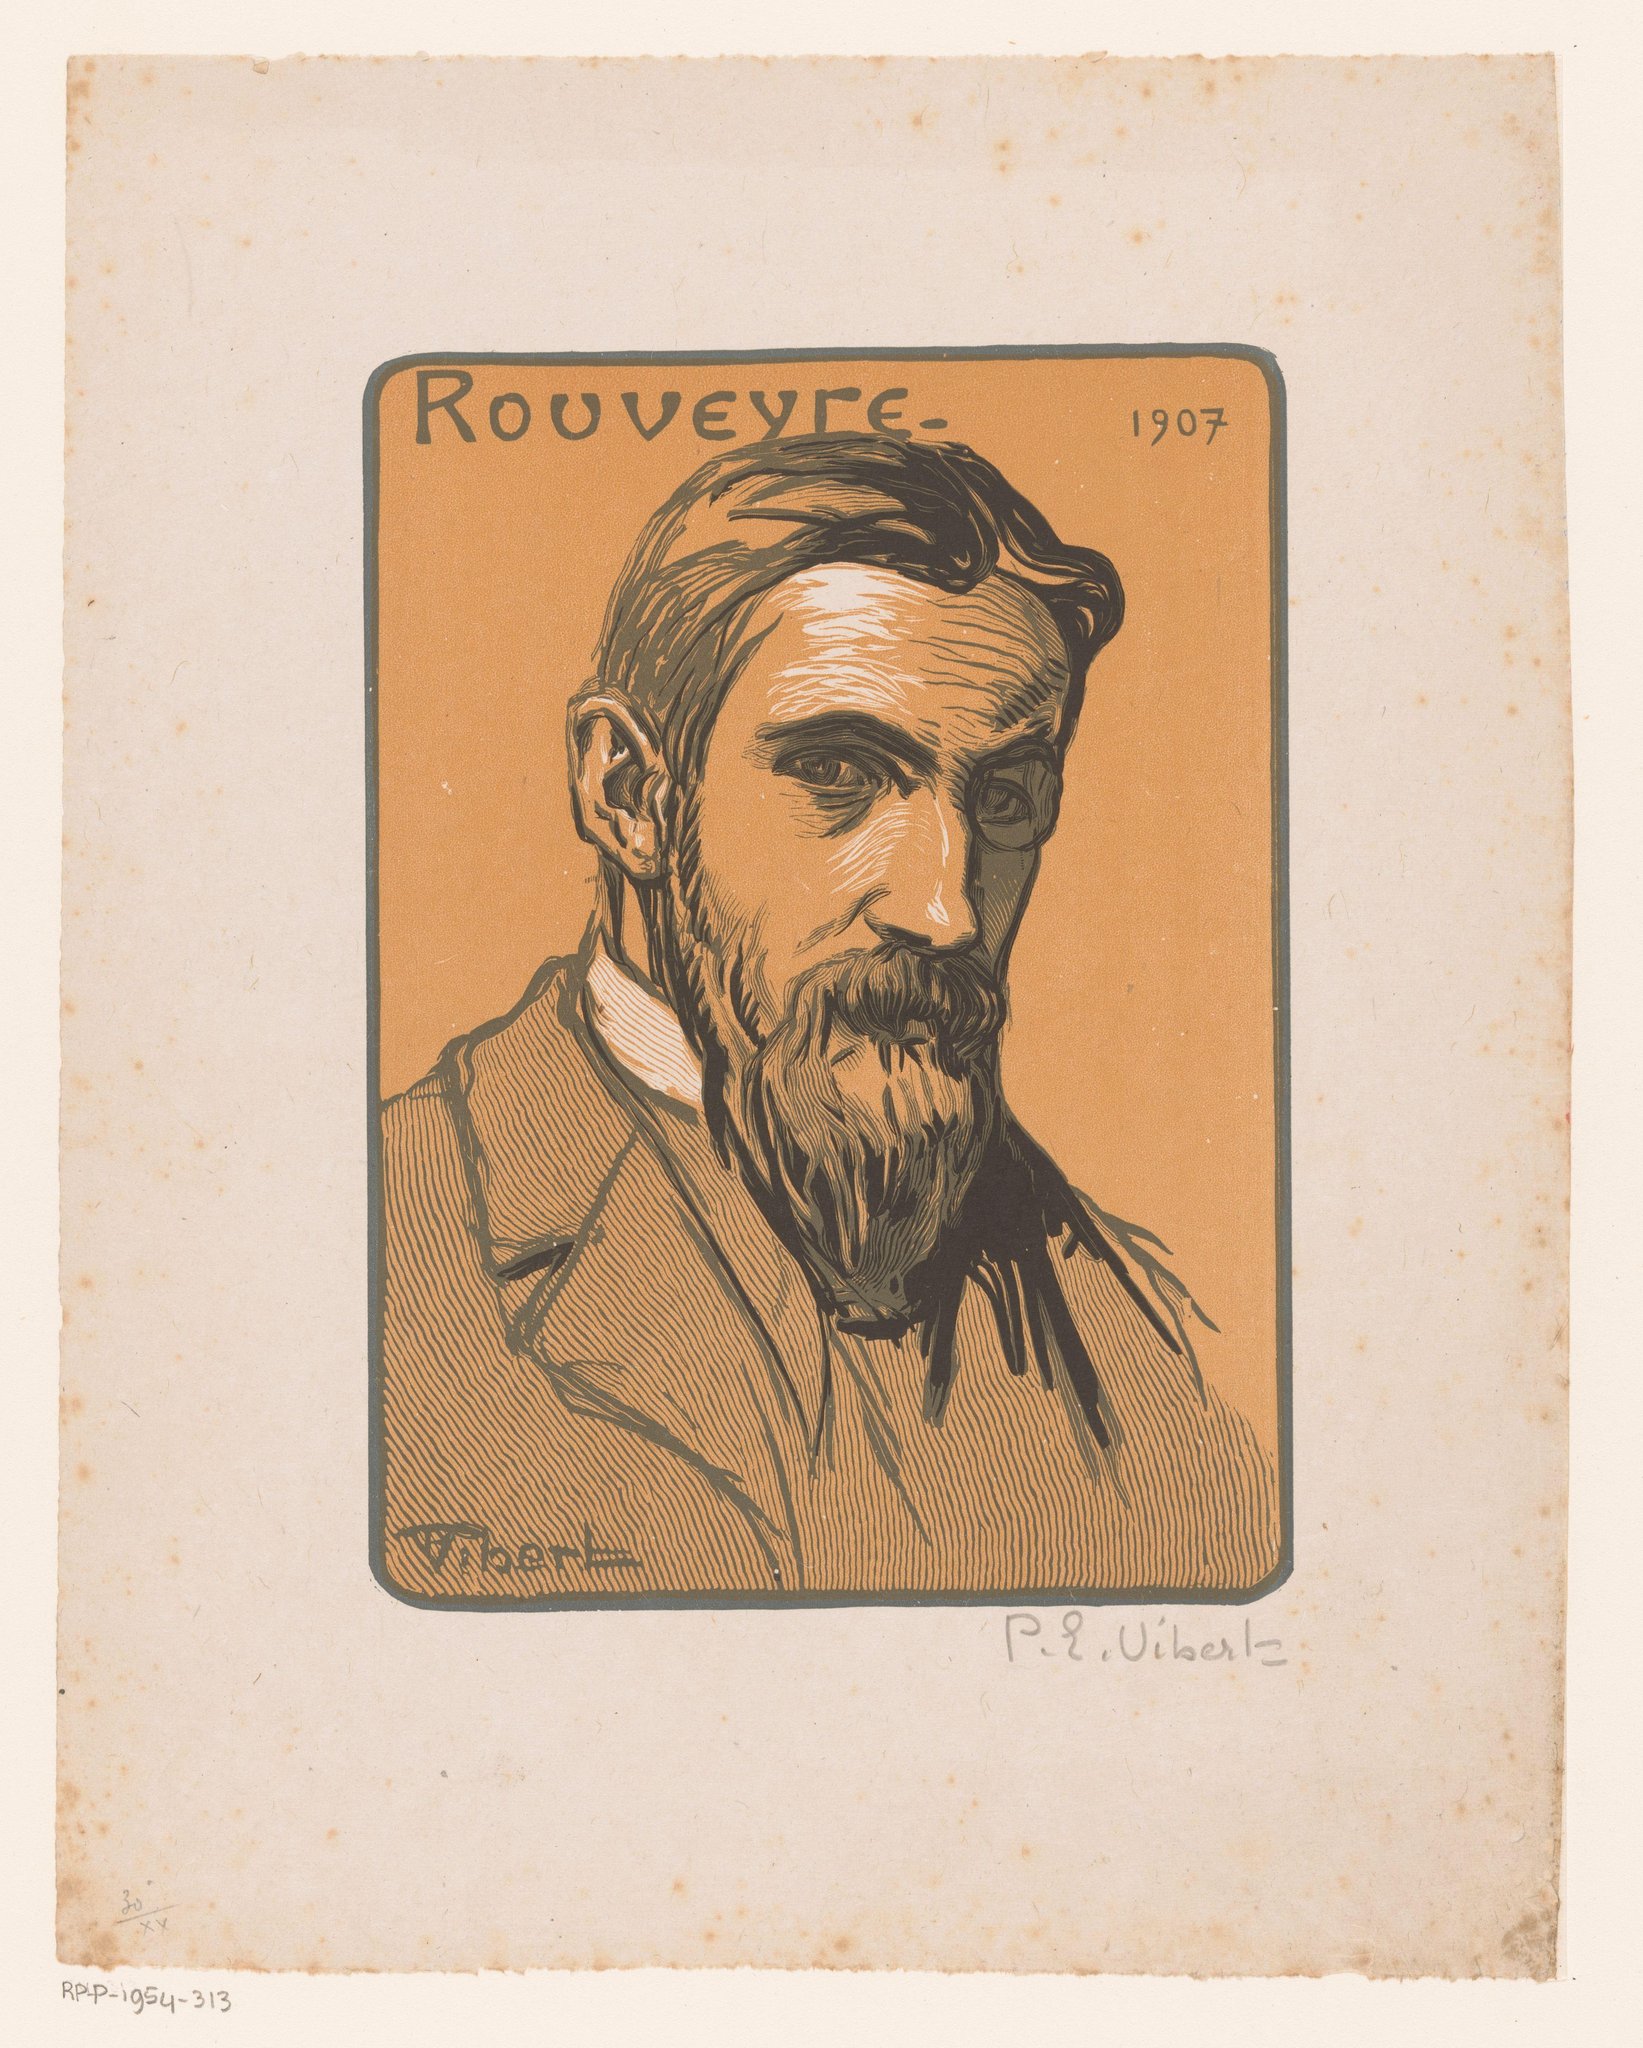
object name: print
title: Portret van André Rouveyre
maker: pierre-eugène vibert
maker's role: print maker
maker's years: 1875-1937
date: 1907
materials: paper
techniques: woodcut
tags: historical persons, portrait of a writer, portrait, self-portrait of painter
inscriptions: collector's mark: Lugt 2760, collector's mark: Lugt 2228